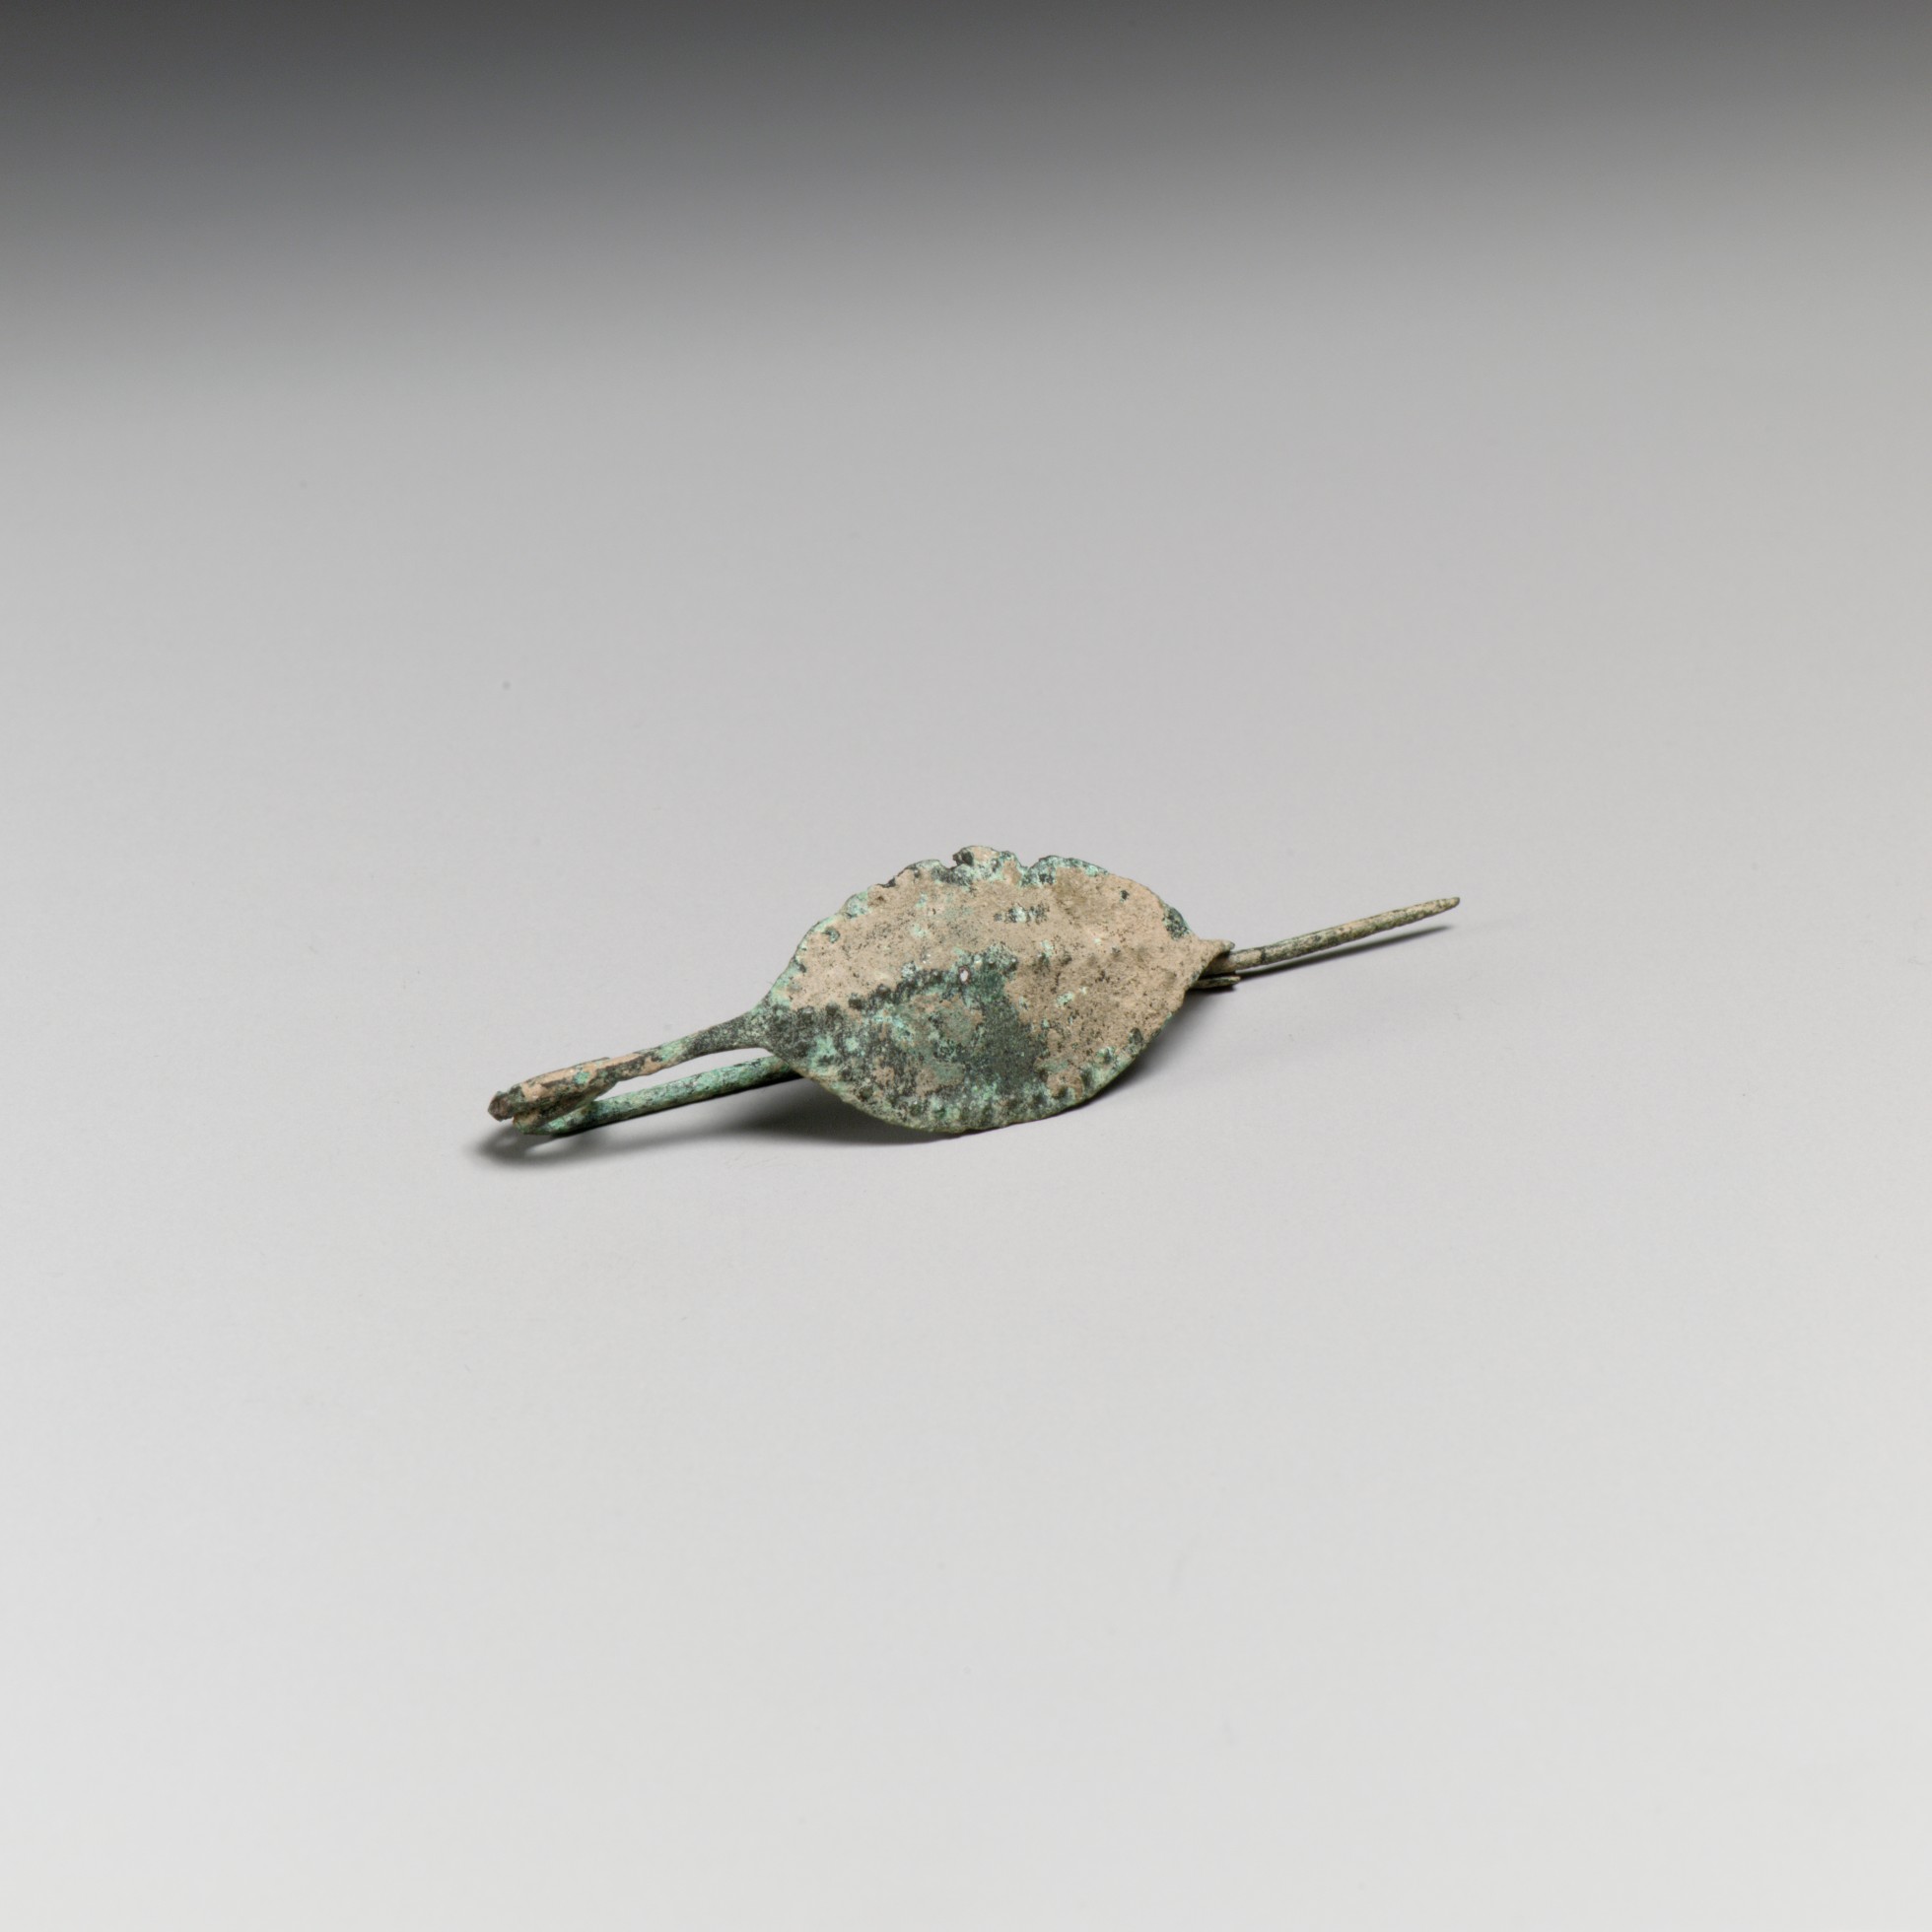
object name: fibula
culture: etruscan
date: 900-100 BCE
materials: bronze